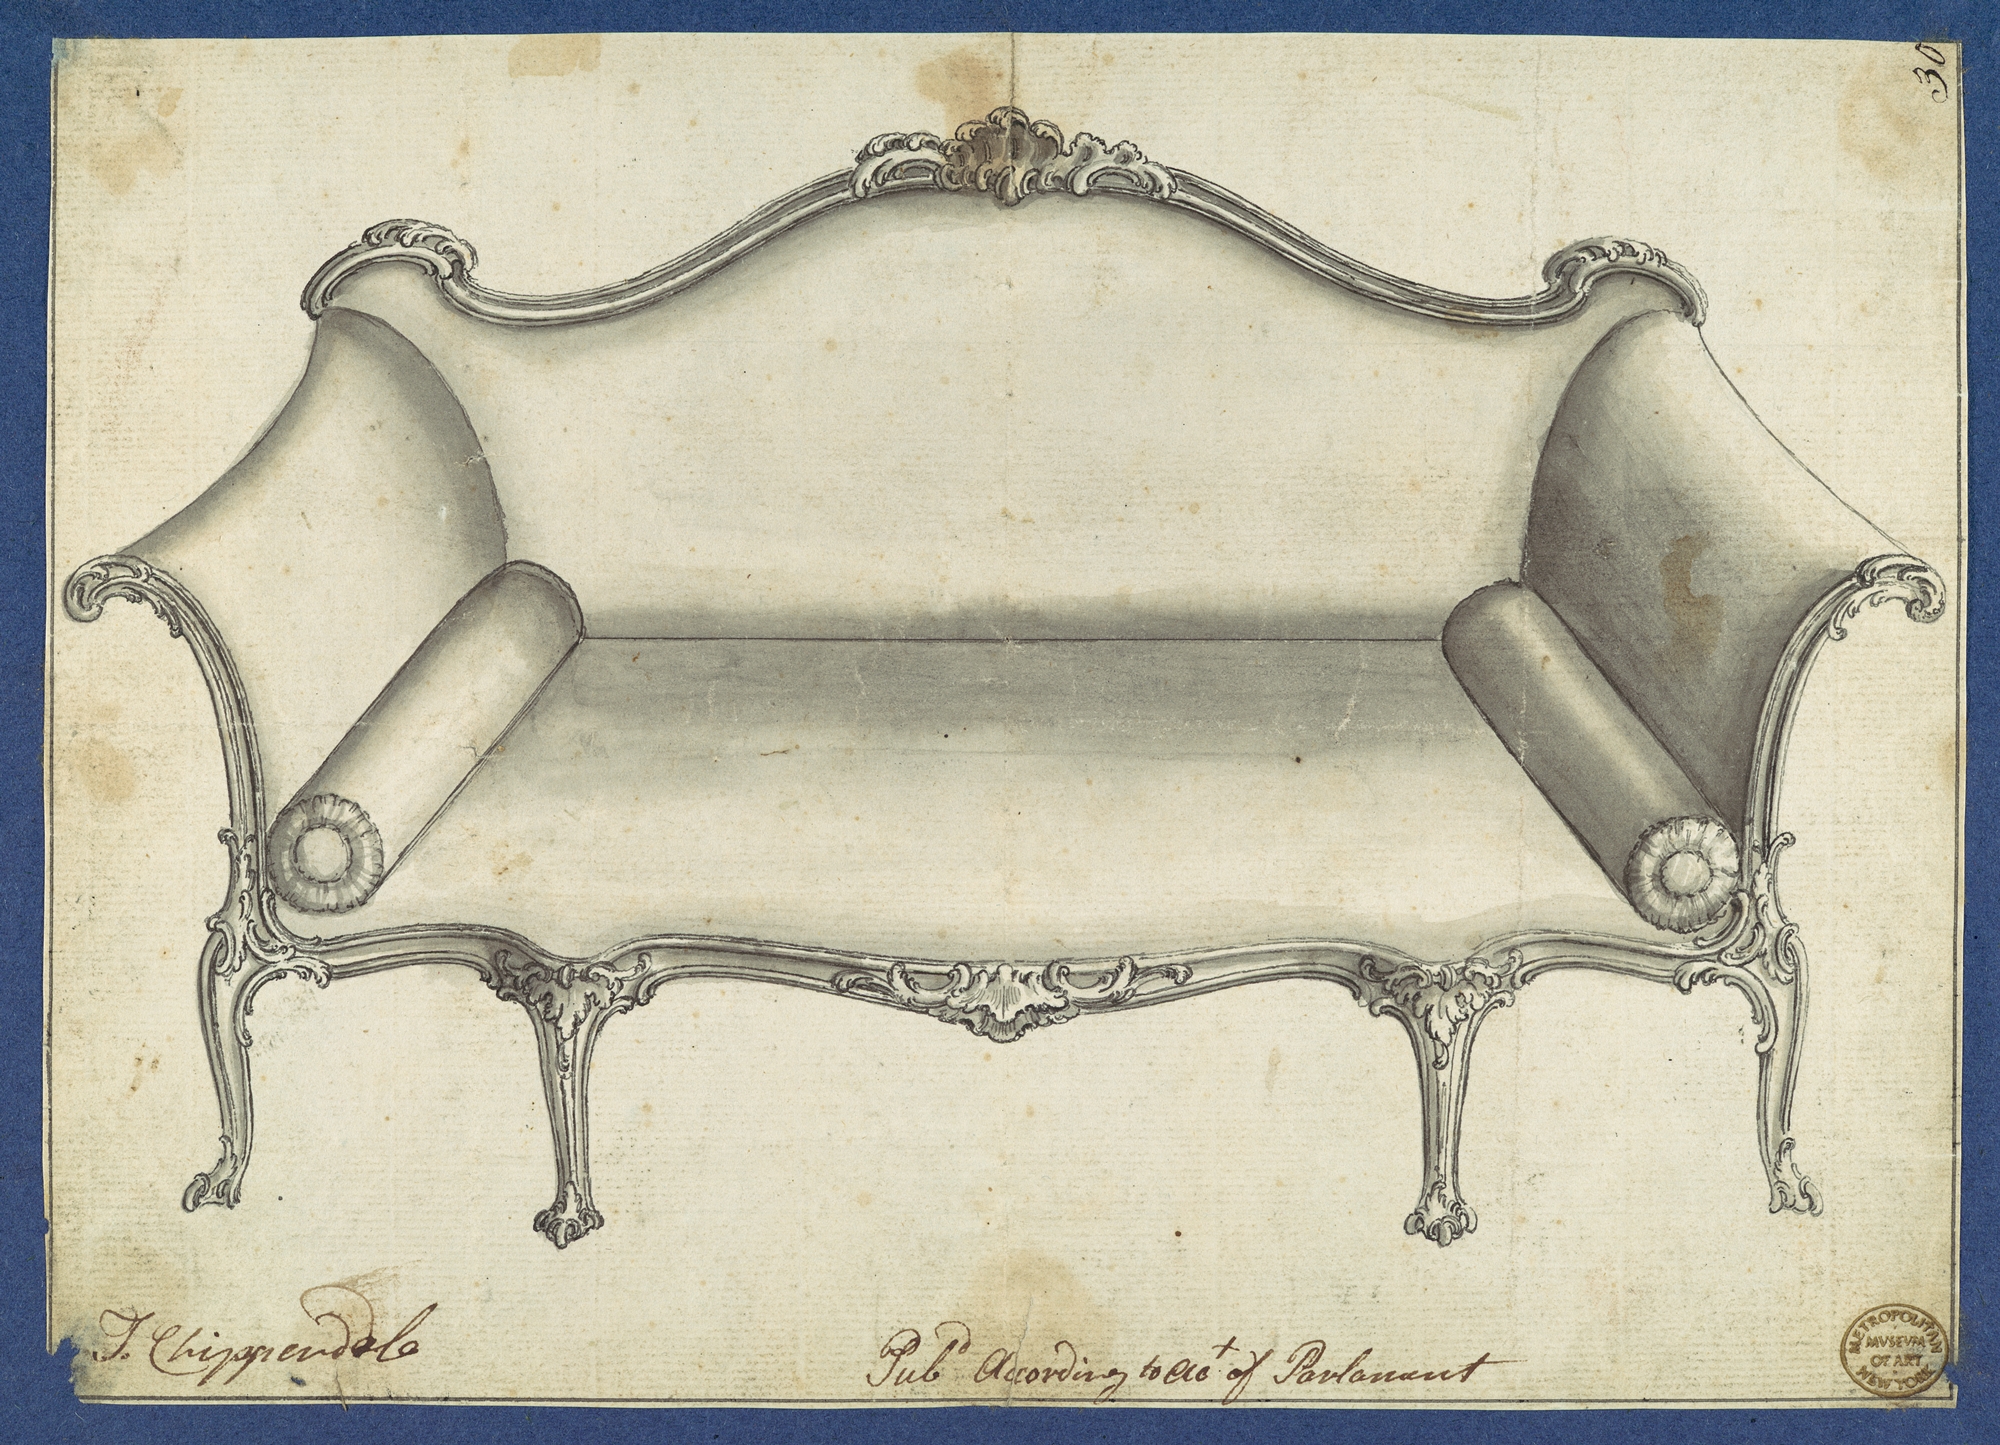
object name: drawing ornament architecture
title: Sofa, in Chippendale Drawings, Vol. I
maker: thomas chippendale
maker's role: artist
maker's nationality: british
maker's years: 1718-1779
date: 1759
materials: ink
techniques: wash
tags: couches